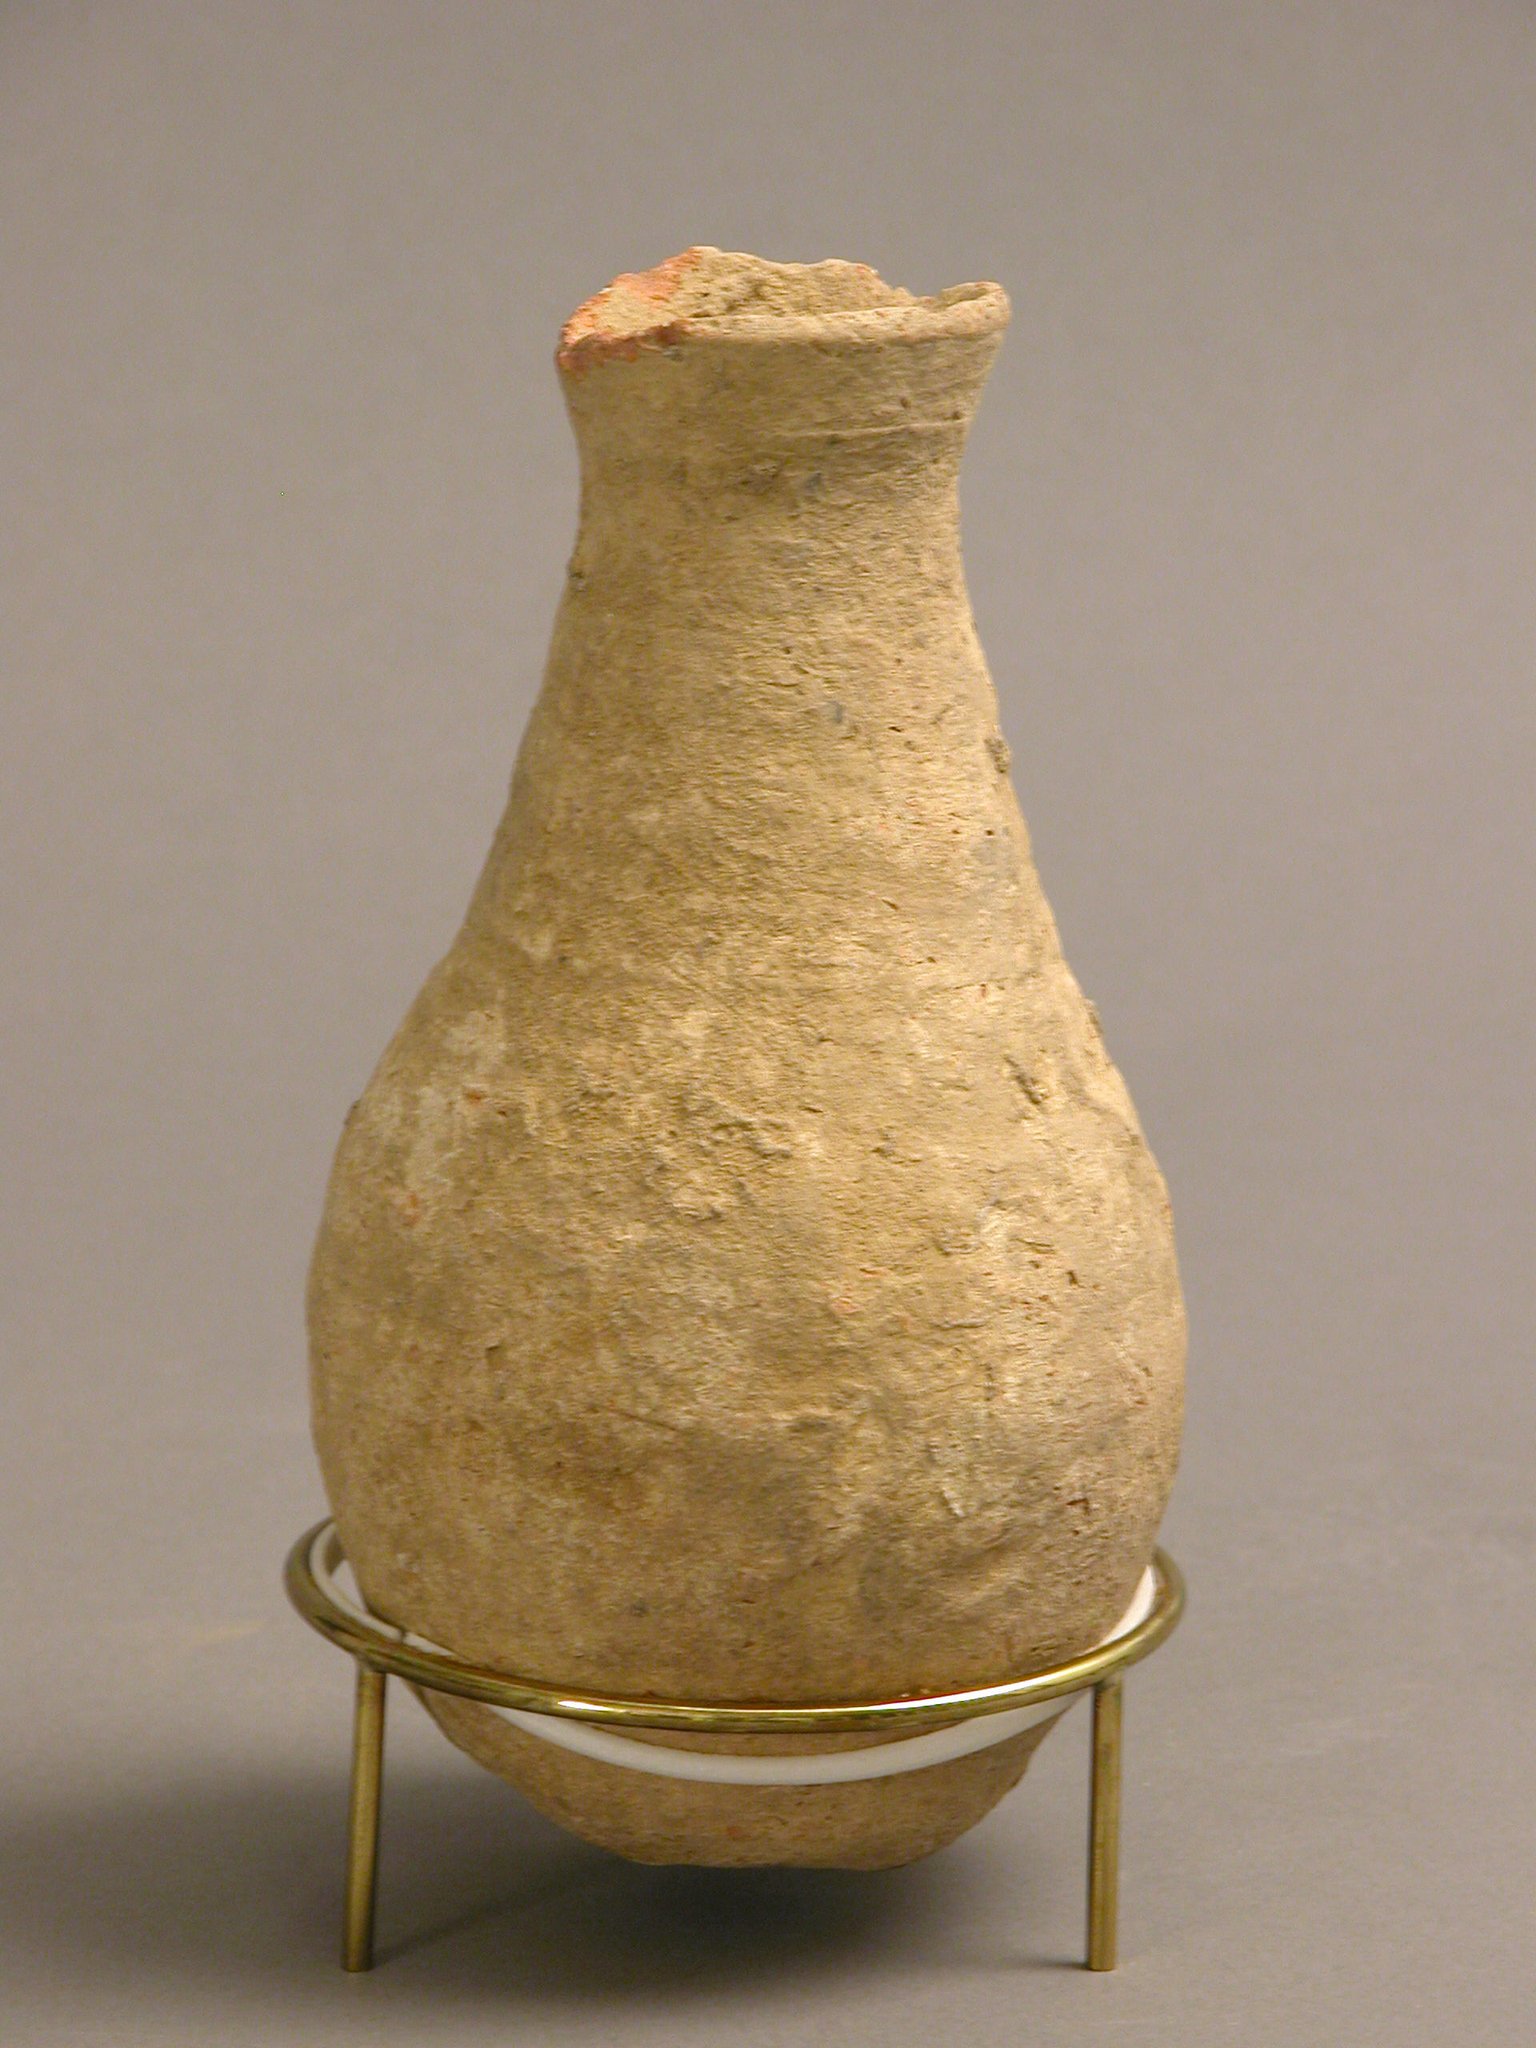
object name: jar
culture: coptic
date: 301-700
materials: earthenware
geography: egypt